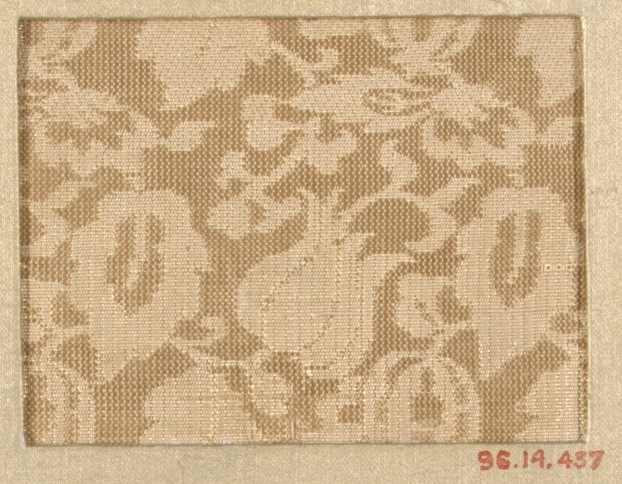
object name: piece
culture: japanese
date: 1701-1900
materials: silk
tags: flowers,leaves